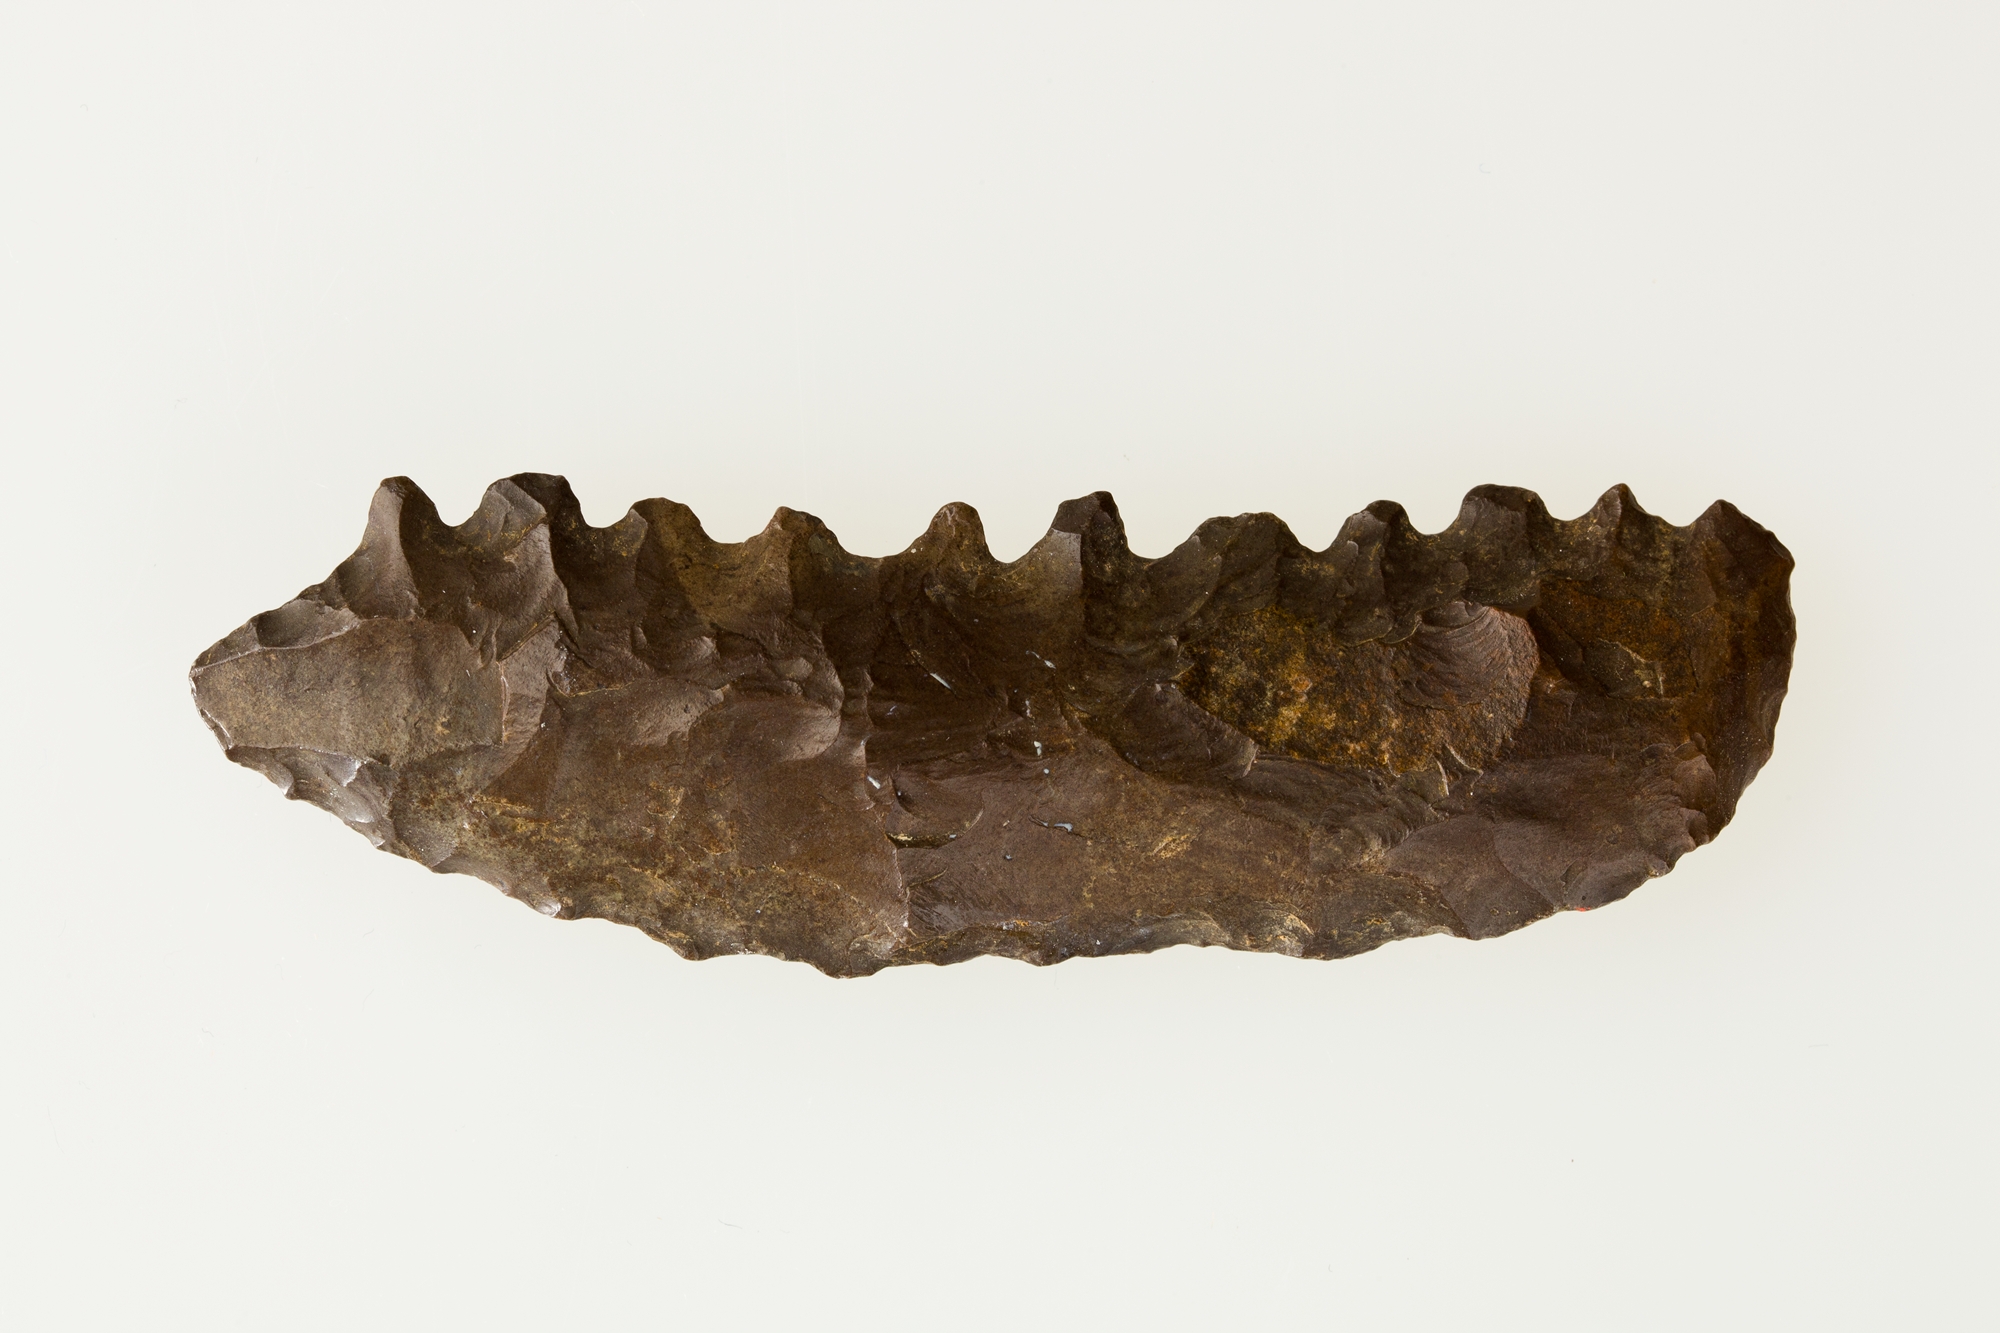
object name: sickle, insert, denticulate, bifacial, tool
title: Bifacial Sickle Insert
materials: stone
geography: egypt